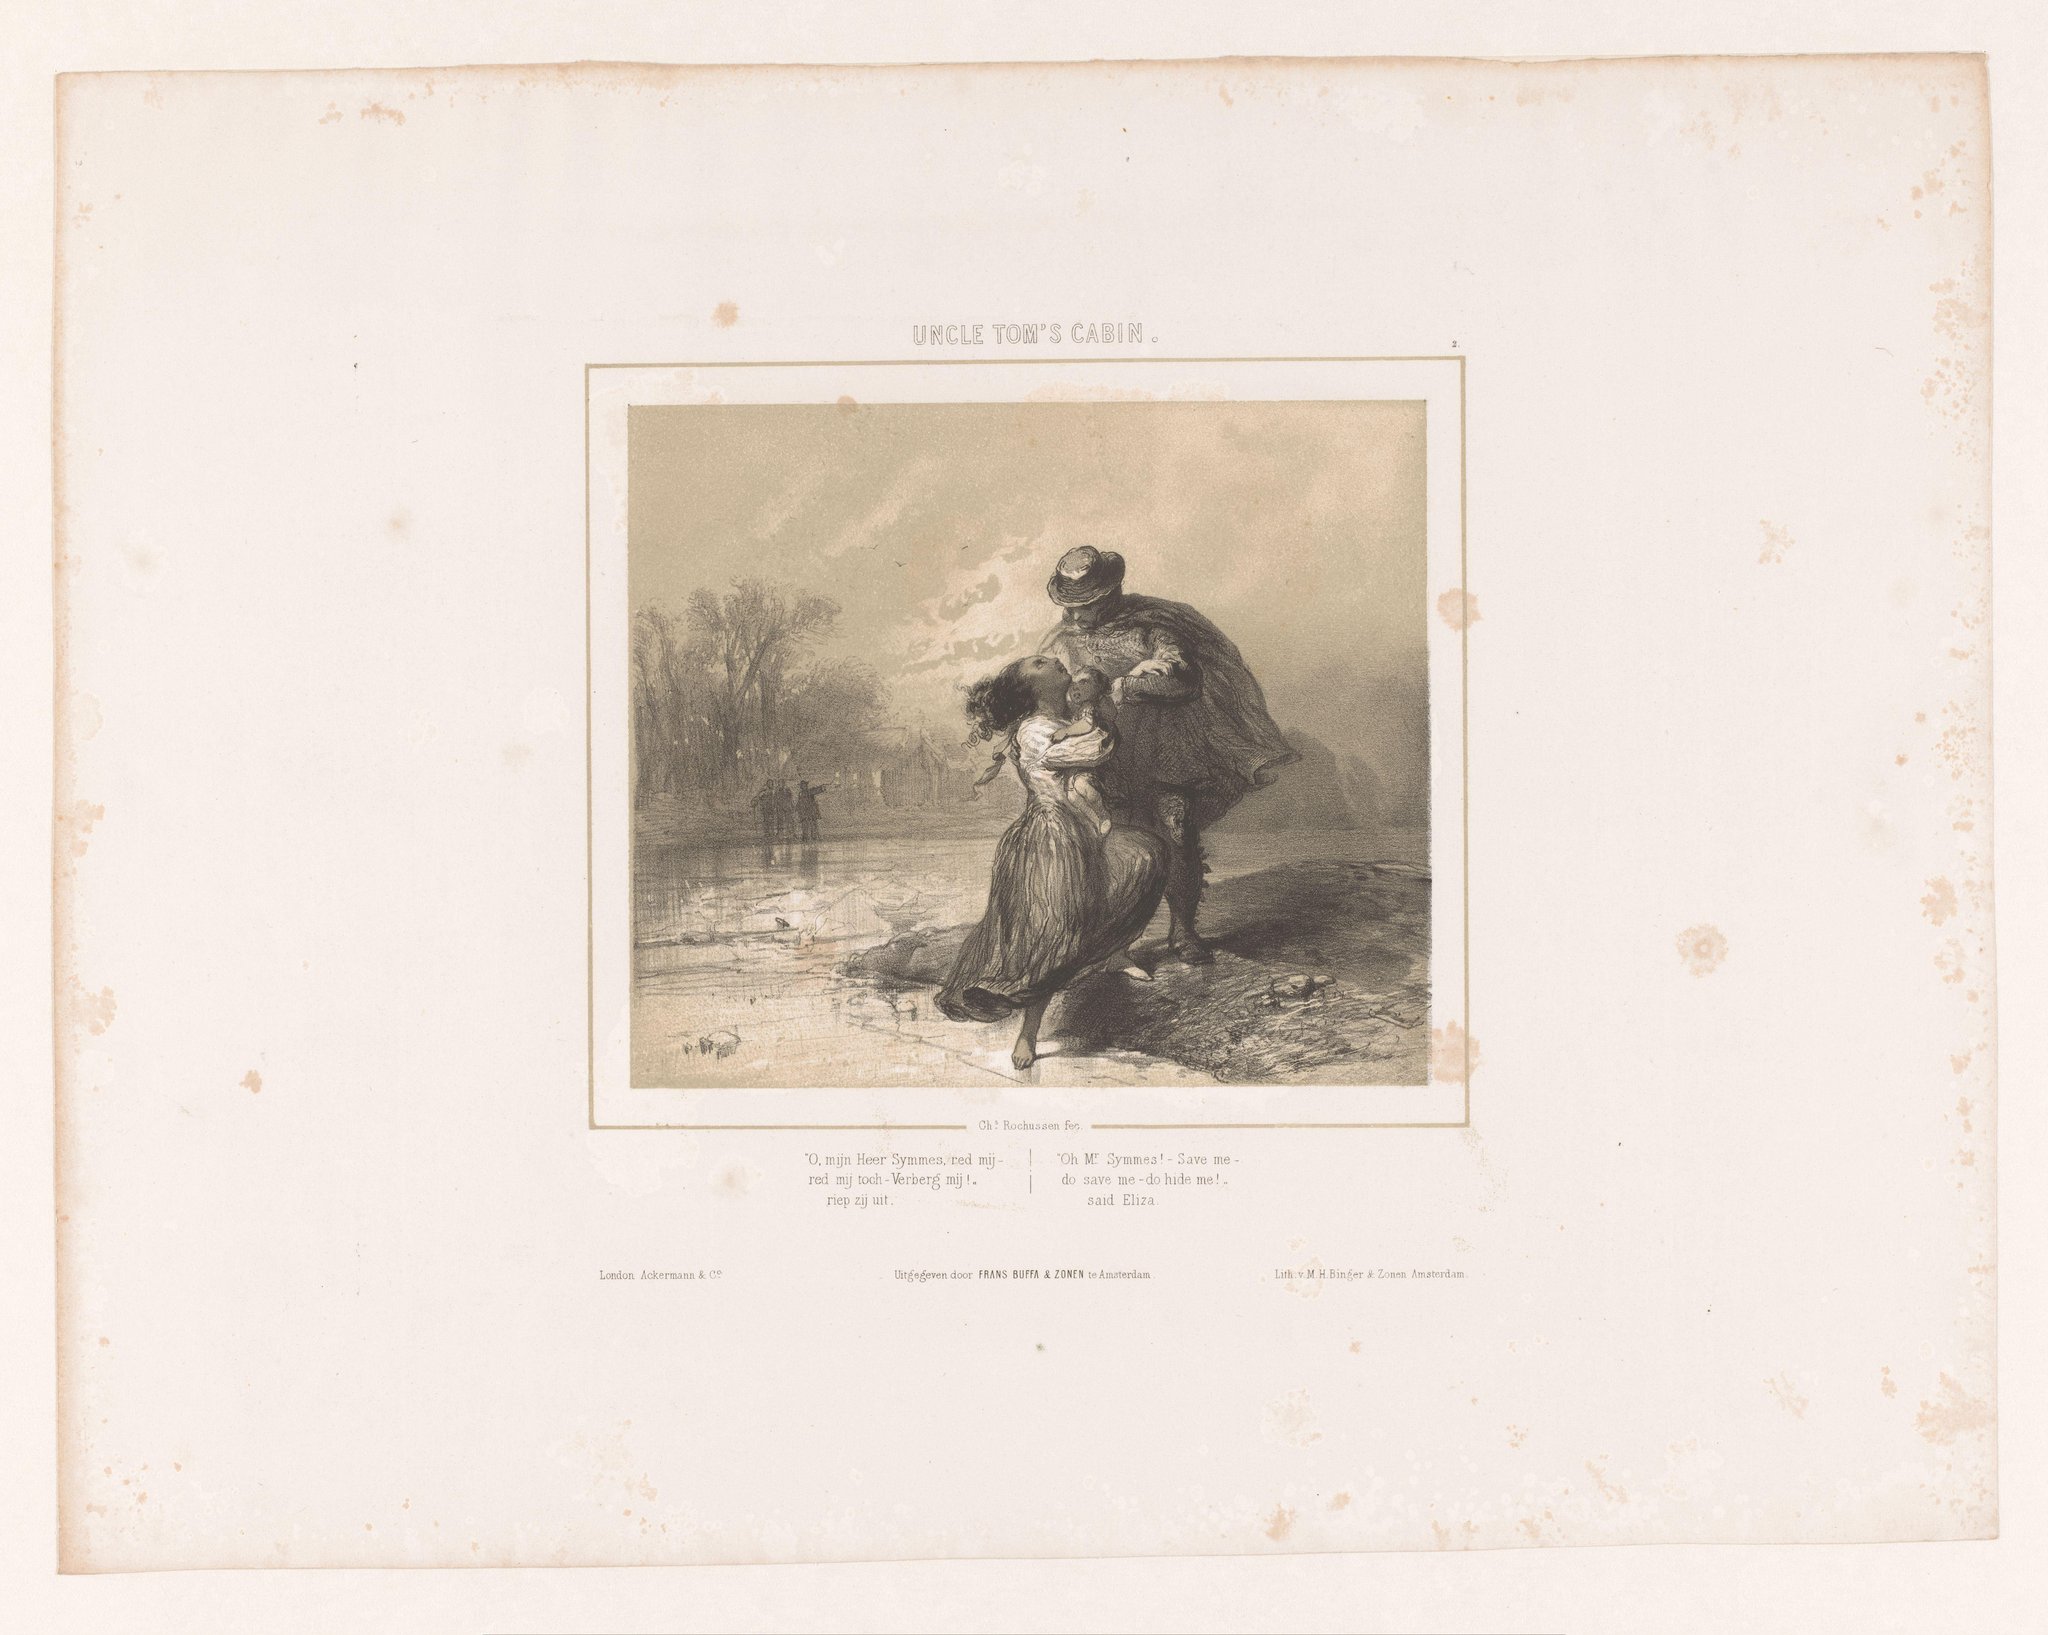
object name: print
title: Uncle Tom's cabin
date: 1850-1856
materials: paper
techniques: tone lithography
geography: amsterdam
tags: help (to an endangered fellow man), mother and baby or young child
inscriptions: collector's mark: Lugt 2228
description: Eliza met haar kind Harry in haar armen heeft de deels bevroren rivier achter haar overgestoken. Naast haar staat meneer Symmes wiens hulp zij vraagt. In de achtergrond staat drie mannen op de oever van de rivier.